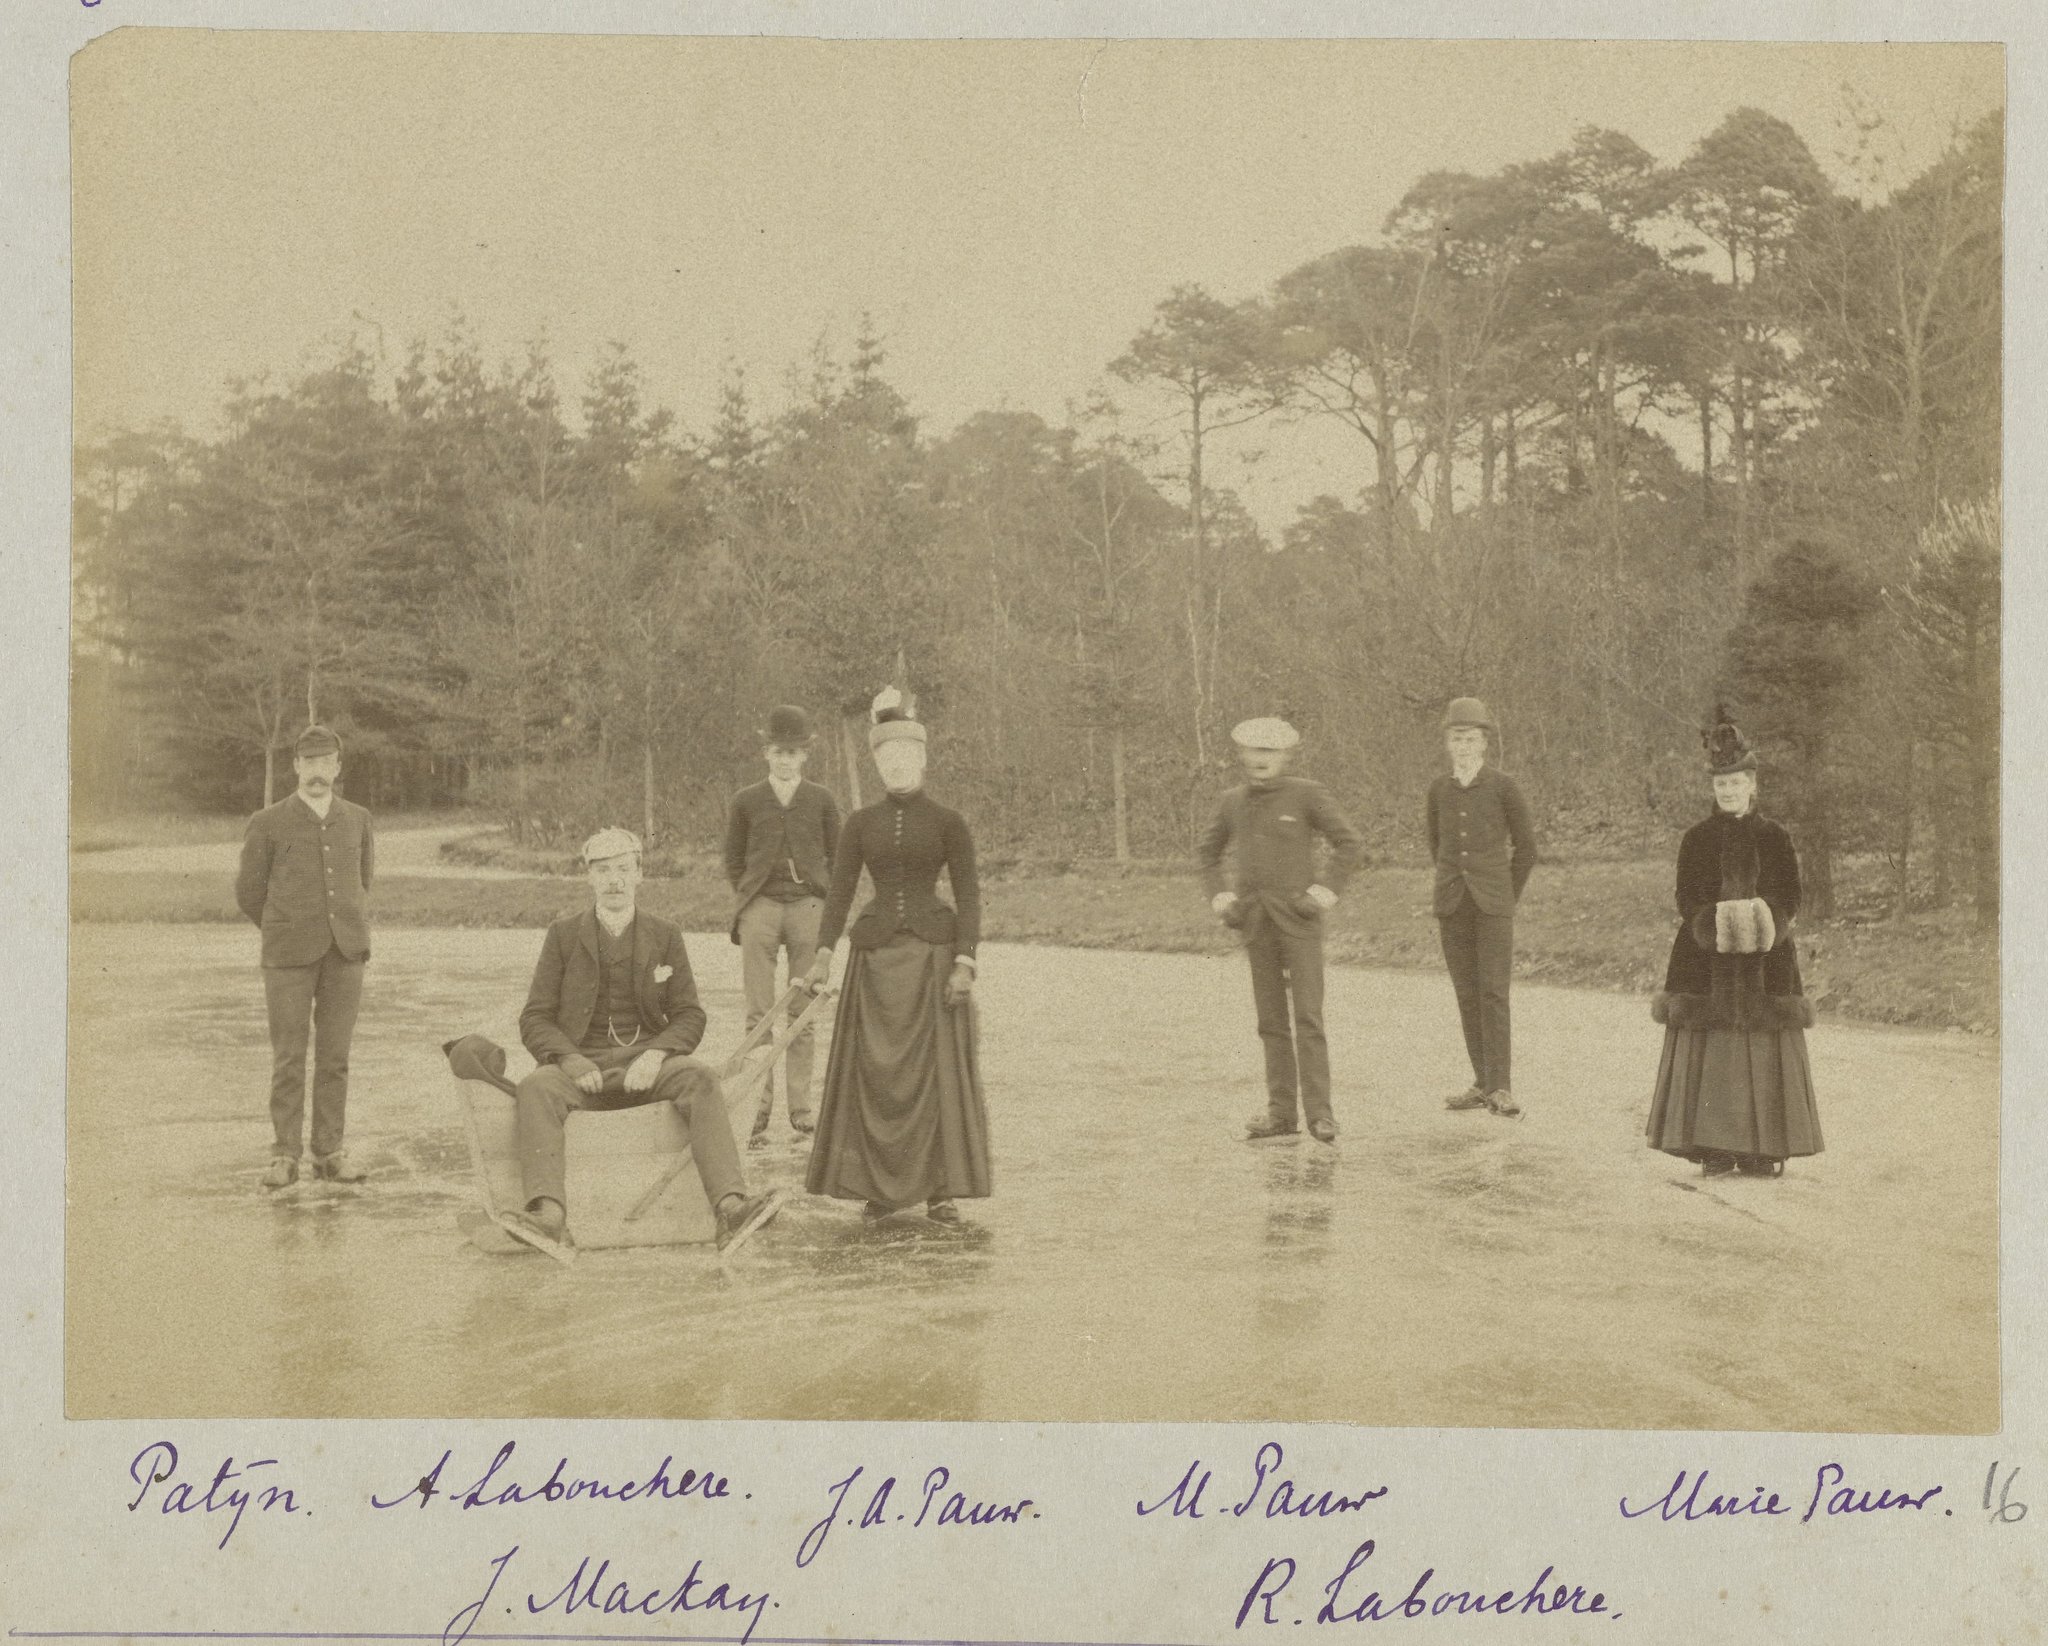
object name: photograph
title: Gezelschap op het ijs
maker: henry pauw van wieldrecht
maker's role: fotograaf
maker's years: 1863-1912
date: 1888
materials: paper, photographic support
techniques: albumen print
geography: netherlands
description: Met onderschrift: Patijn, A. Labouchere J. Mackay, J.A. Pauw, R. Labouchere, Marie Pauw.